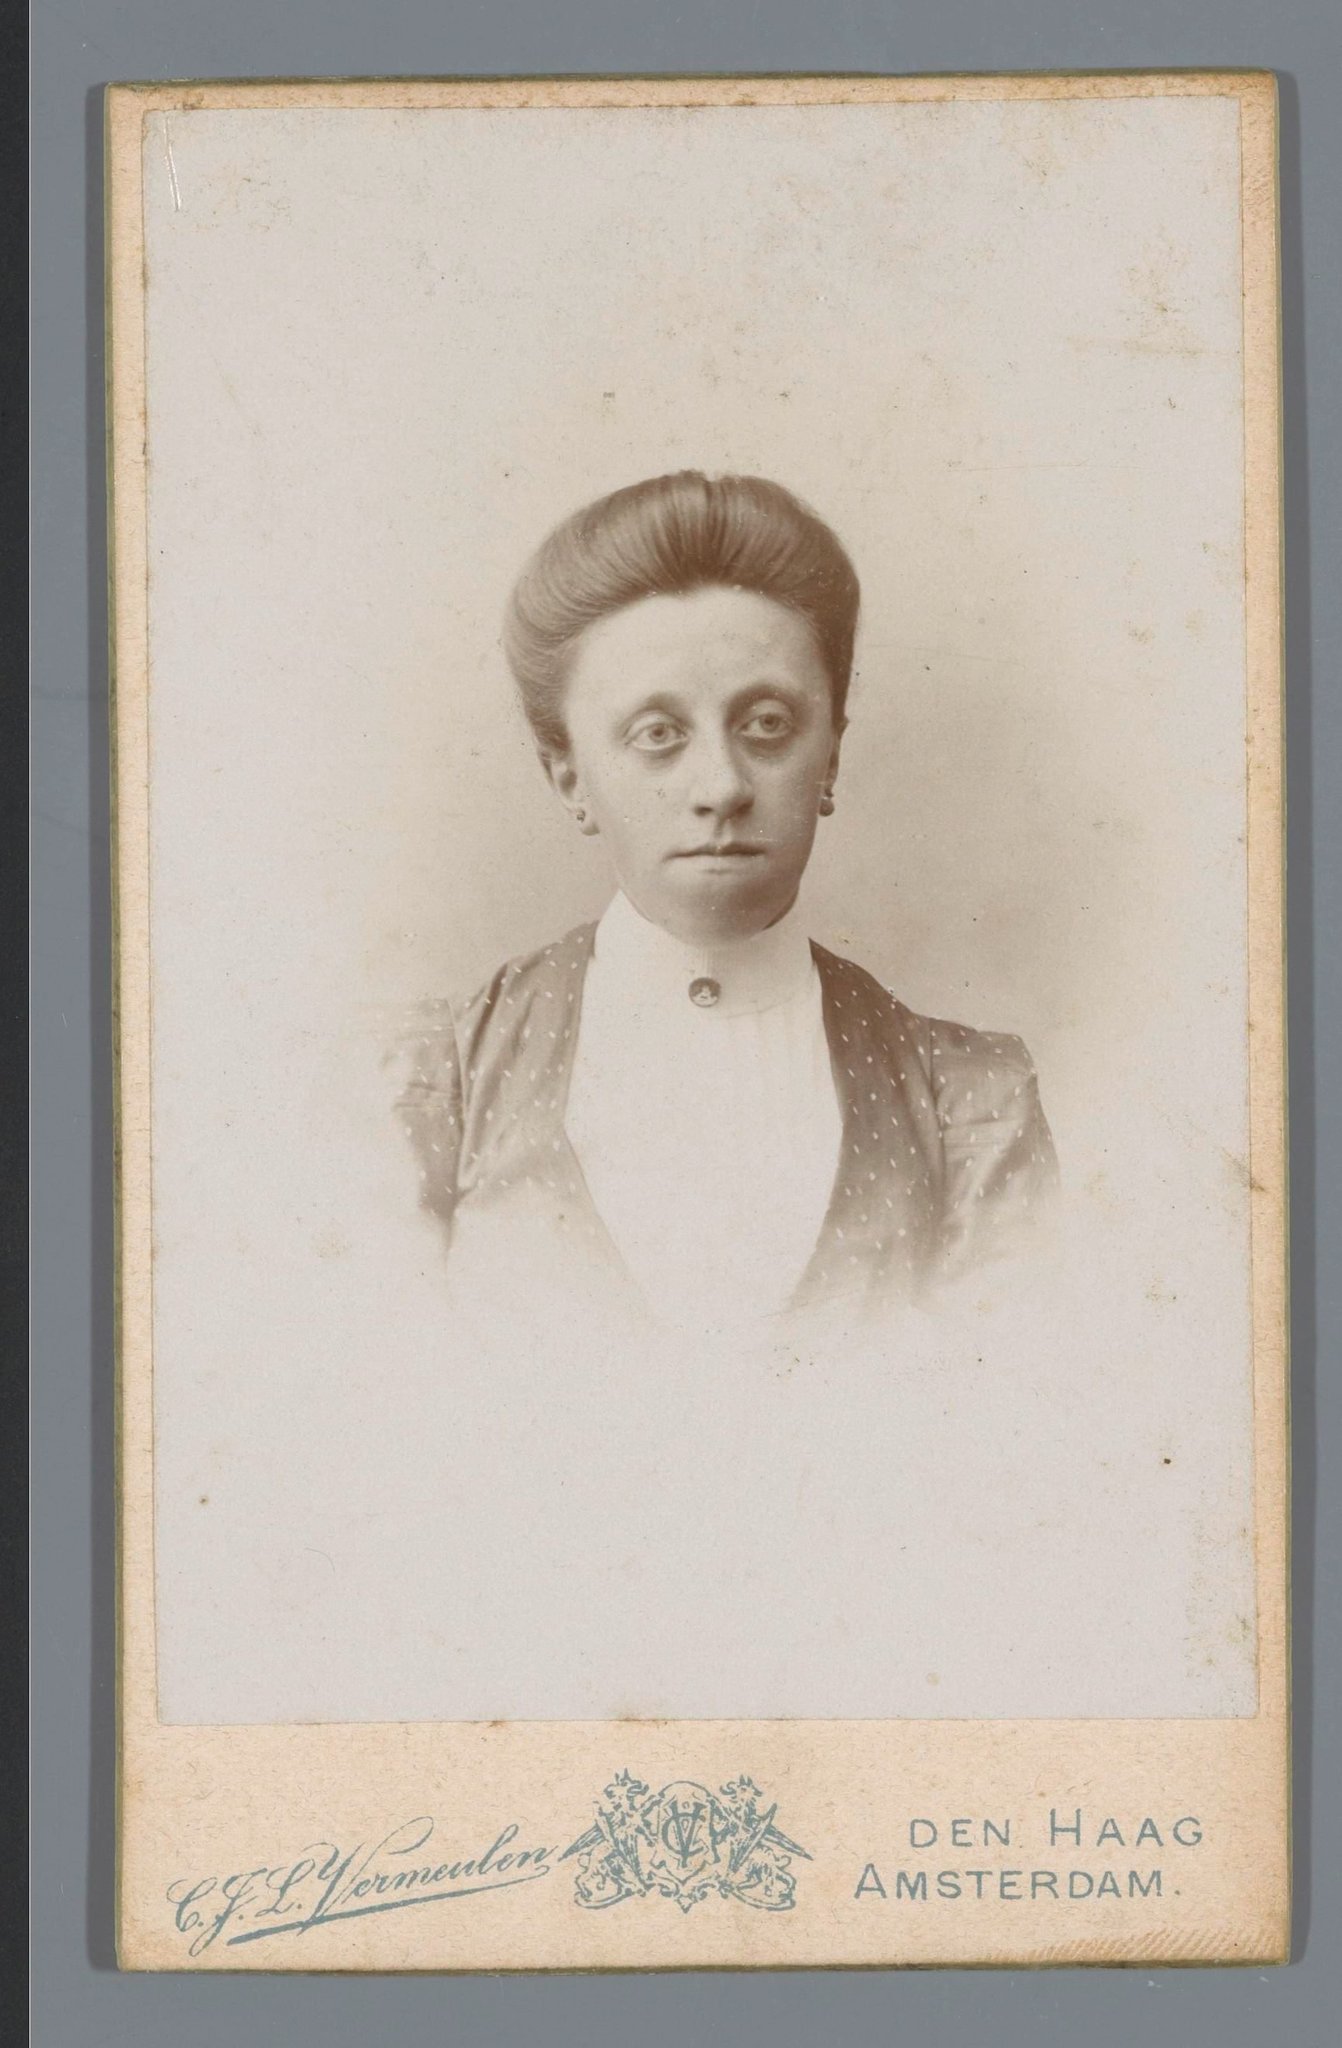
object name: photograph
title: Portret van een onbekende vrouw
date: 1890-1915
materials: cardboard, photographic support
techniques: collodion silver print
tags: historical persons - bb - woman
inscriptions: inscription: ‘C. J. L. Vermeulen/ Heiligenweg hoek Singel/ Heerenstraat 6./ Telephoon No. 2339 en 2340./ AMSTERDAM./ Toussaintkade 11./ DEN HAAG./ Intercommunal Telephoon: 774.’